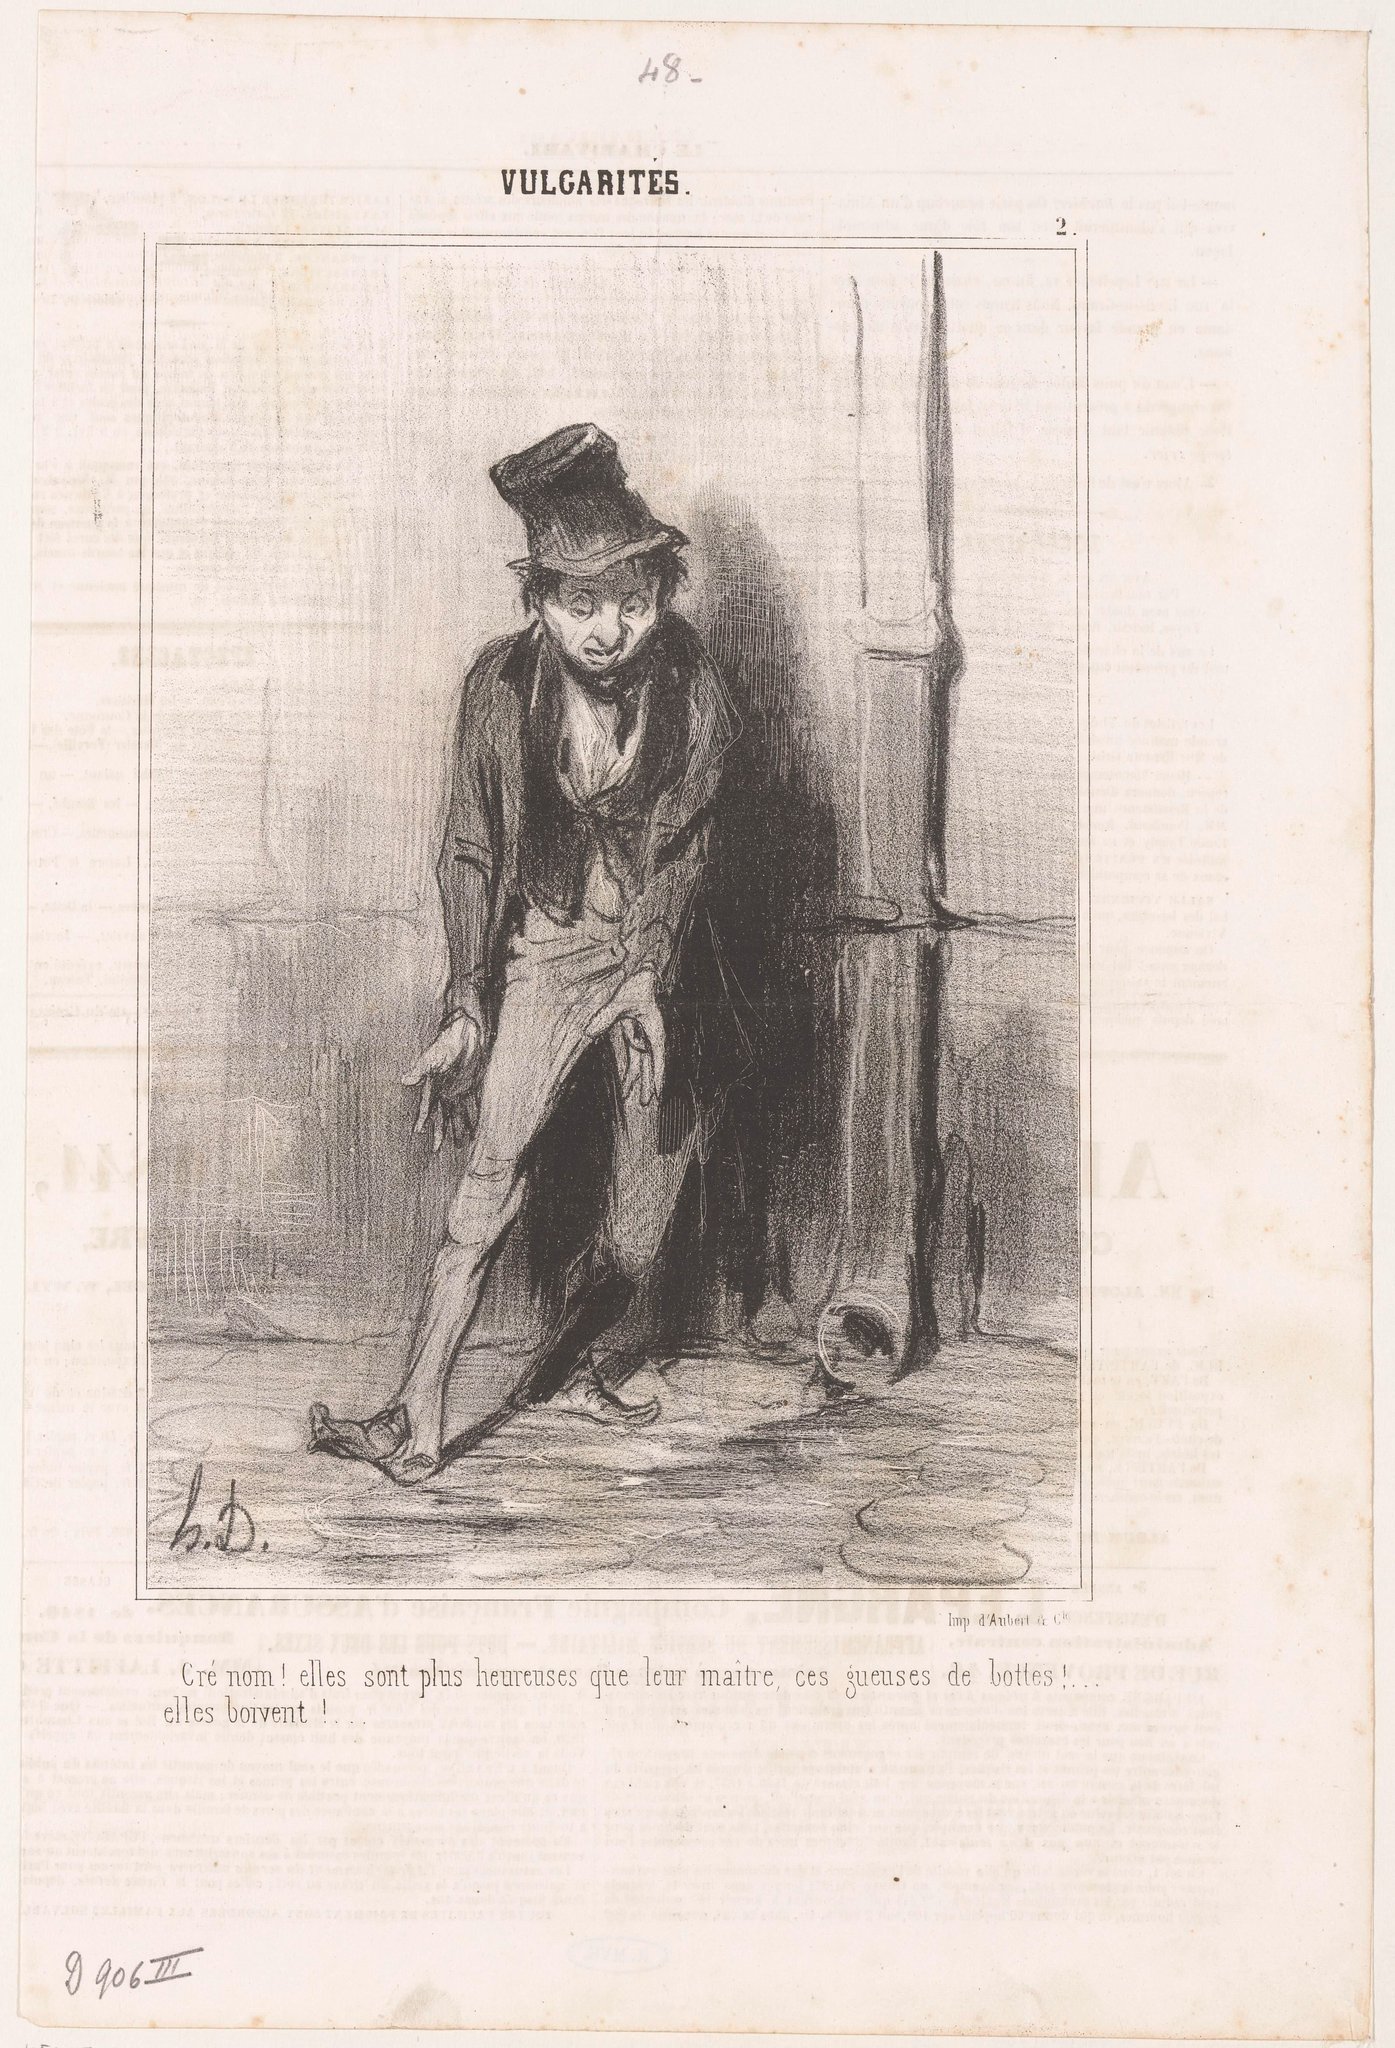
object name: cartoon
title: Banale situaties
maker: honoré daumier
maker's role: draughtsman, painter, print maker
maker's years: 1808-1879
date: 1841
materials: paper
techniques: letterpress printing, lithograph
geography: paris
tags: caricatures (human types), clothed in rags, drunkard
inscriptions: collector's mark: Lugt 2228a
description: Prent mogelijk uit: Le Charivari, 12 maart 1841.